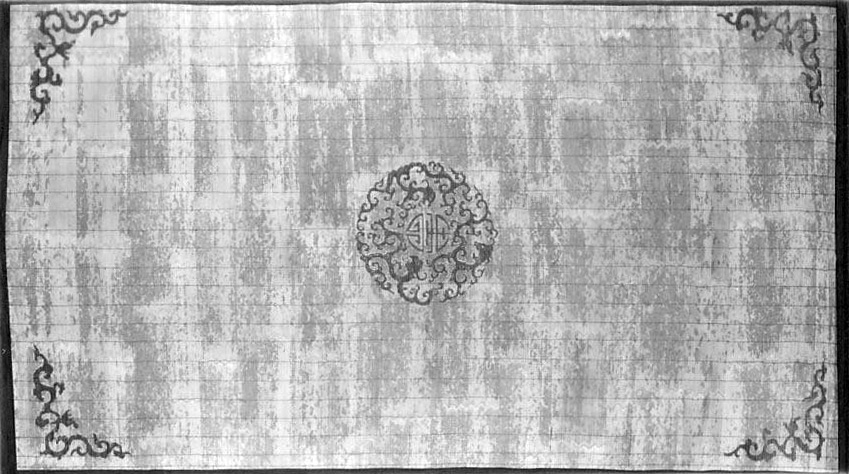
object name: blind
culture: chinese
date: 1662-1722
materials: bamboo, cotton, paint, silk